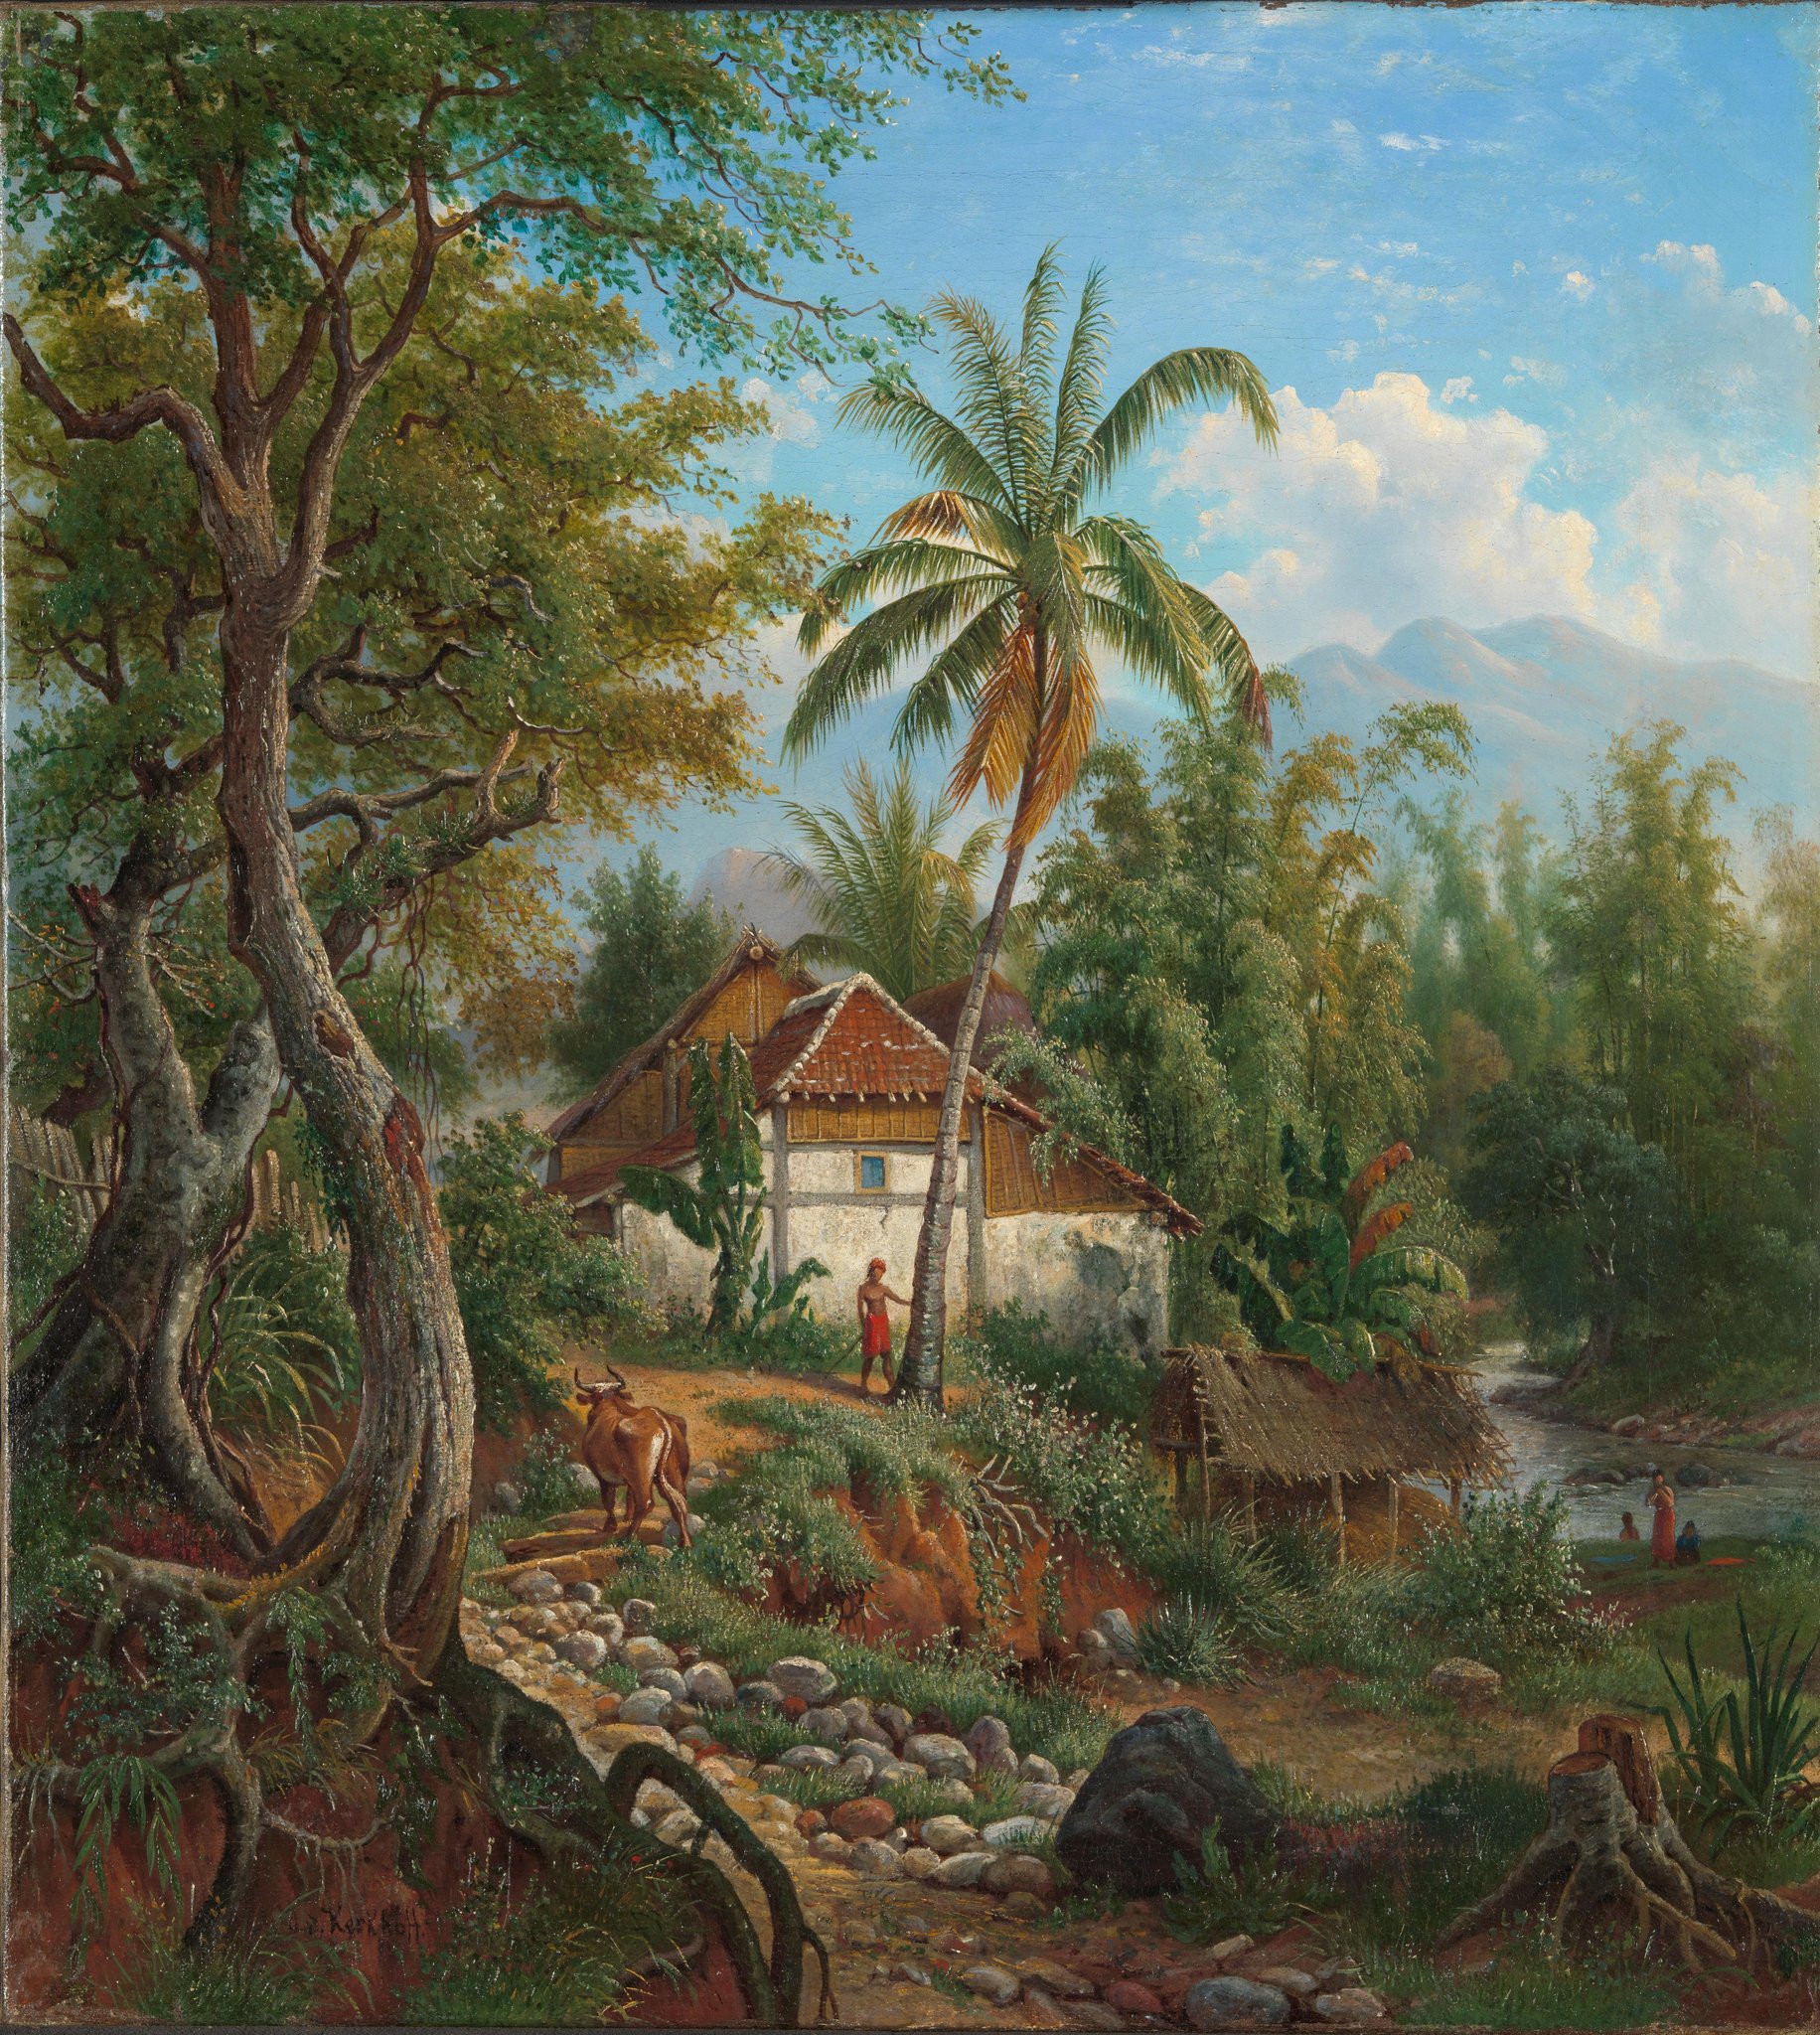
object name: painting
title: Landscape in the Dutch East Indies (Java?)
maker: maurits e.h.r. van den kerkhoff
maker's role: painter, print maker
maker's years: 1830-1908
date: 1858-1908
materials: canvas, oil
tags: landscapes in tropical and sub-tropical regions, dutch east indies, the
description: In 1858, the then 28-year-old Dutch painter Maurits van den Kerkhoff moved to Java, an island in Indonesia, which was a Dutch colony at the time. Van den Kerkhoff painted Javanese landscapes in a European manner. All the elements are rendered in detail, but with little regard for reality. The light is evenly distributed, giving the scene an air of artificiality.